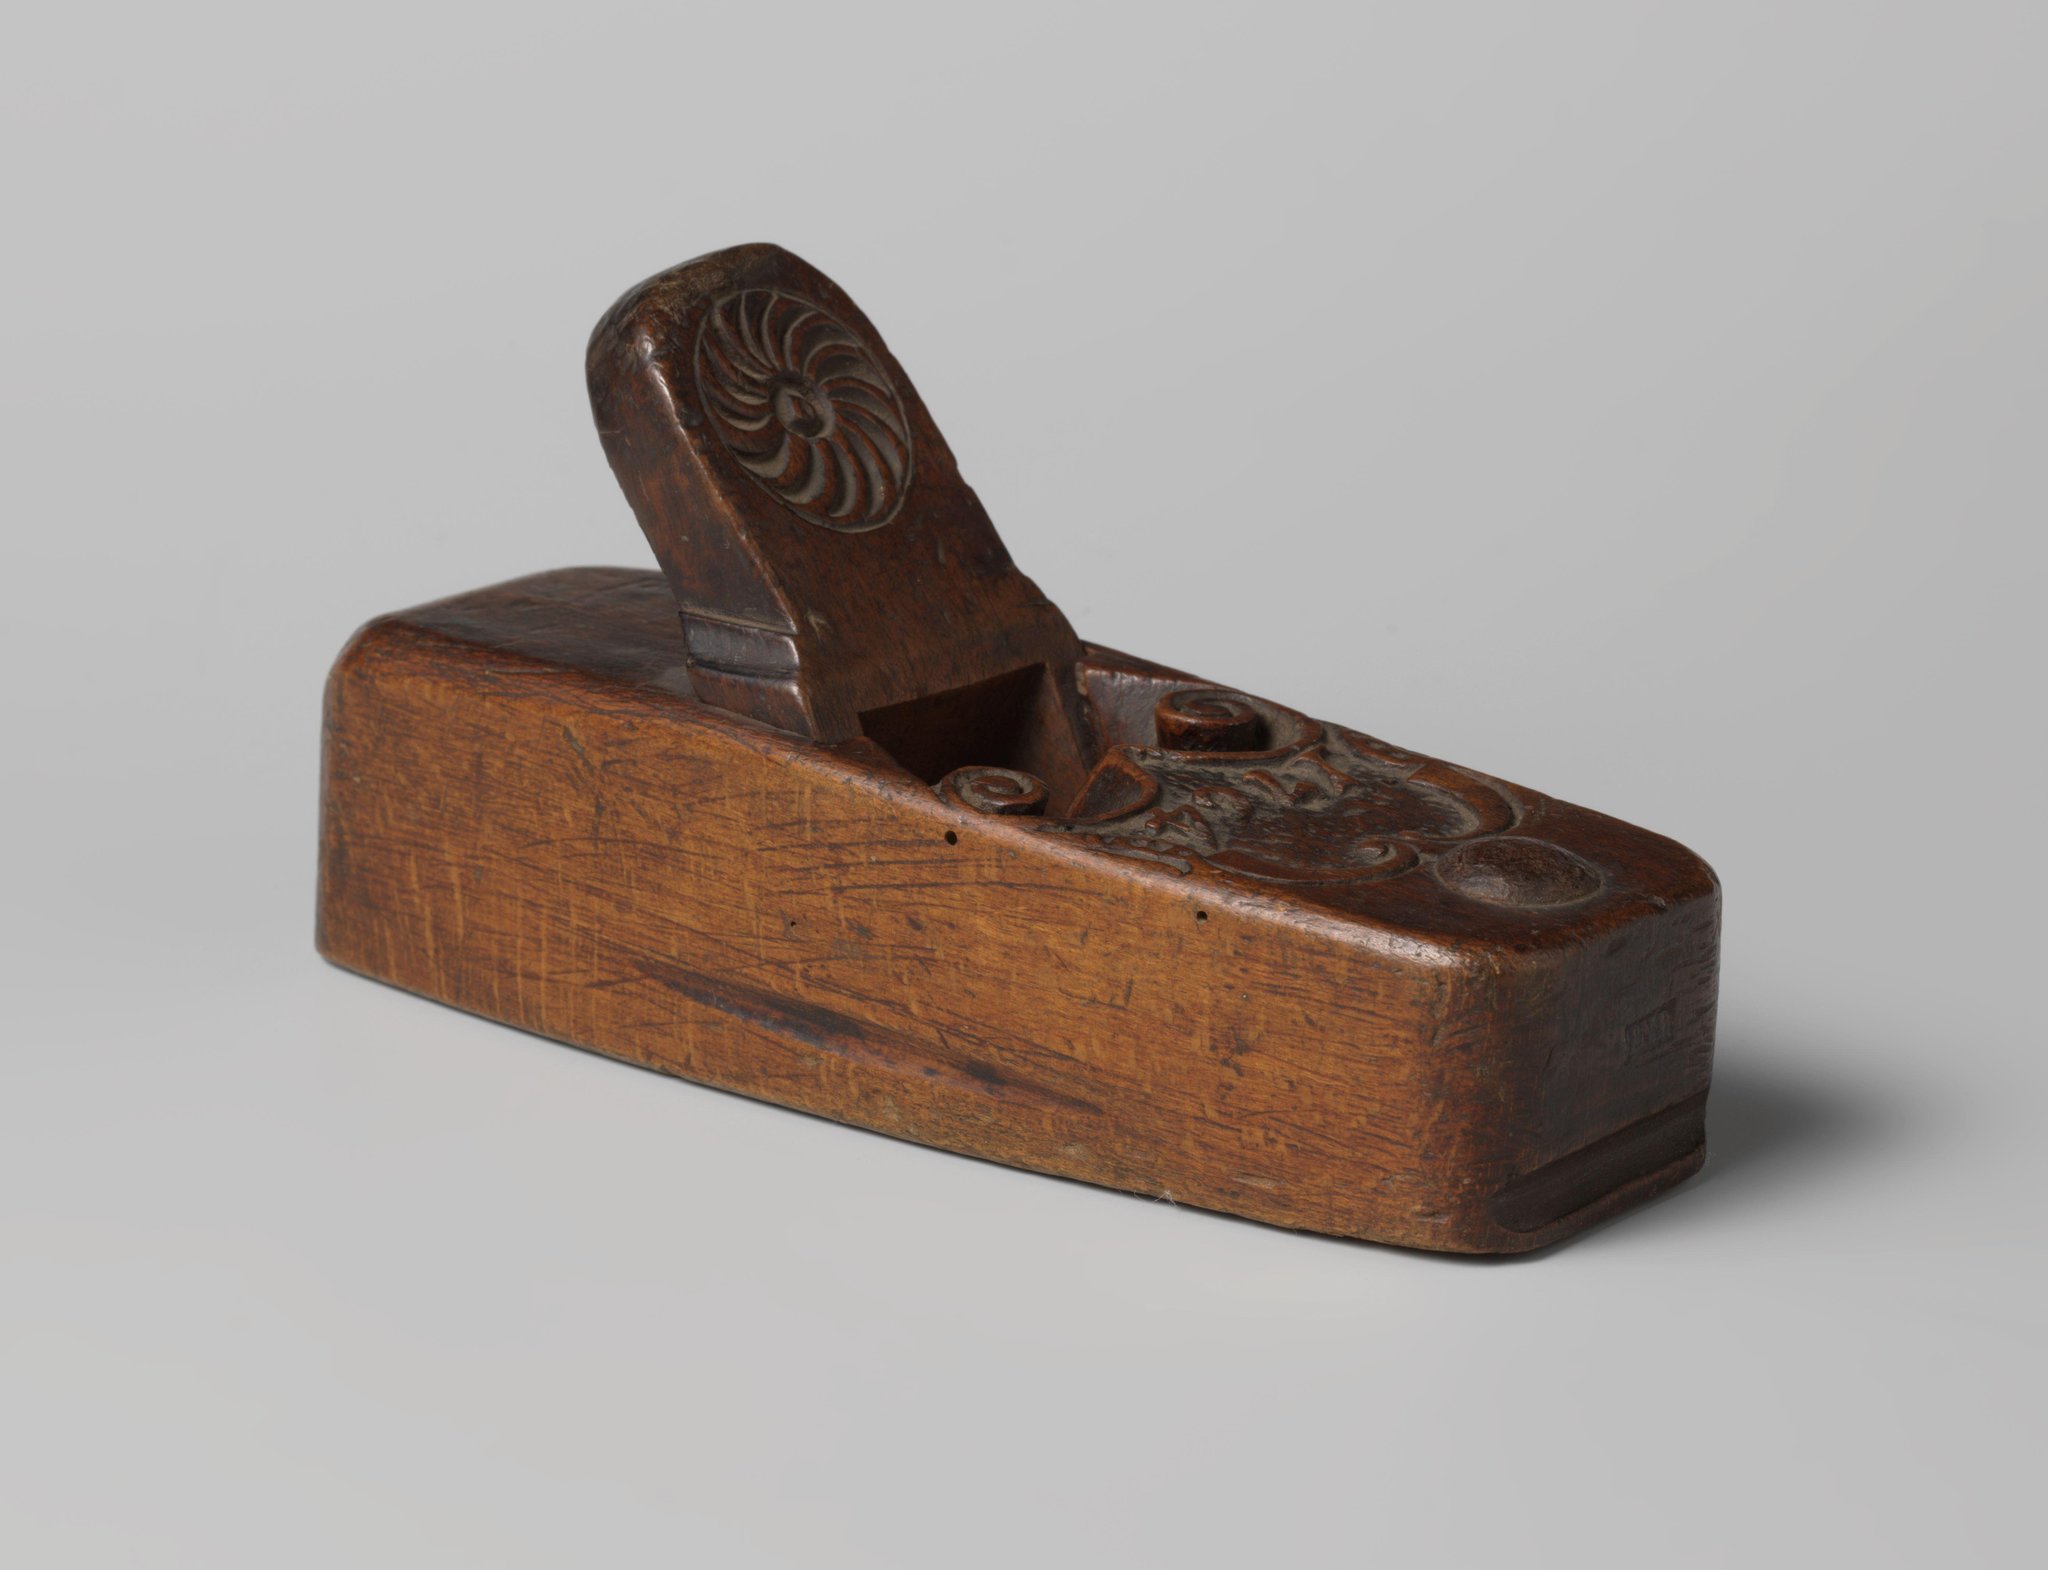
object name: woodworking tool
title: Een houten schaaf uit 1764, met enig snijwerk.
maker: Anonymous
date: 1764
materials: wood, iron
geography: netherlands